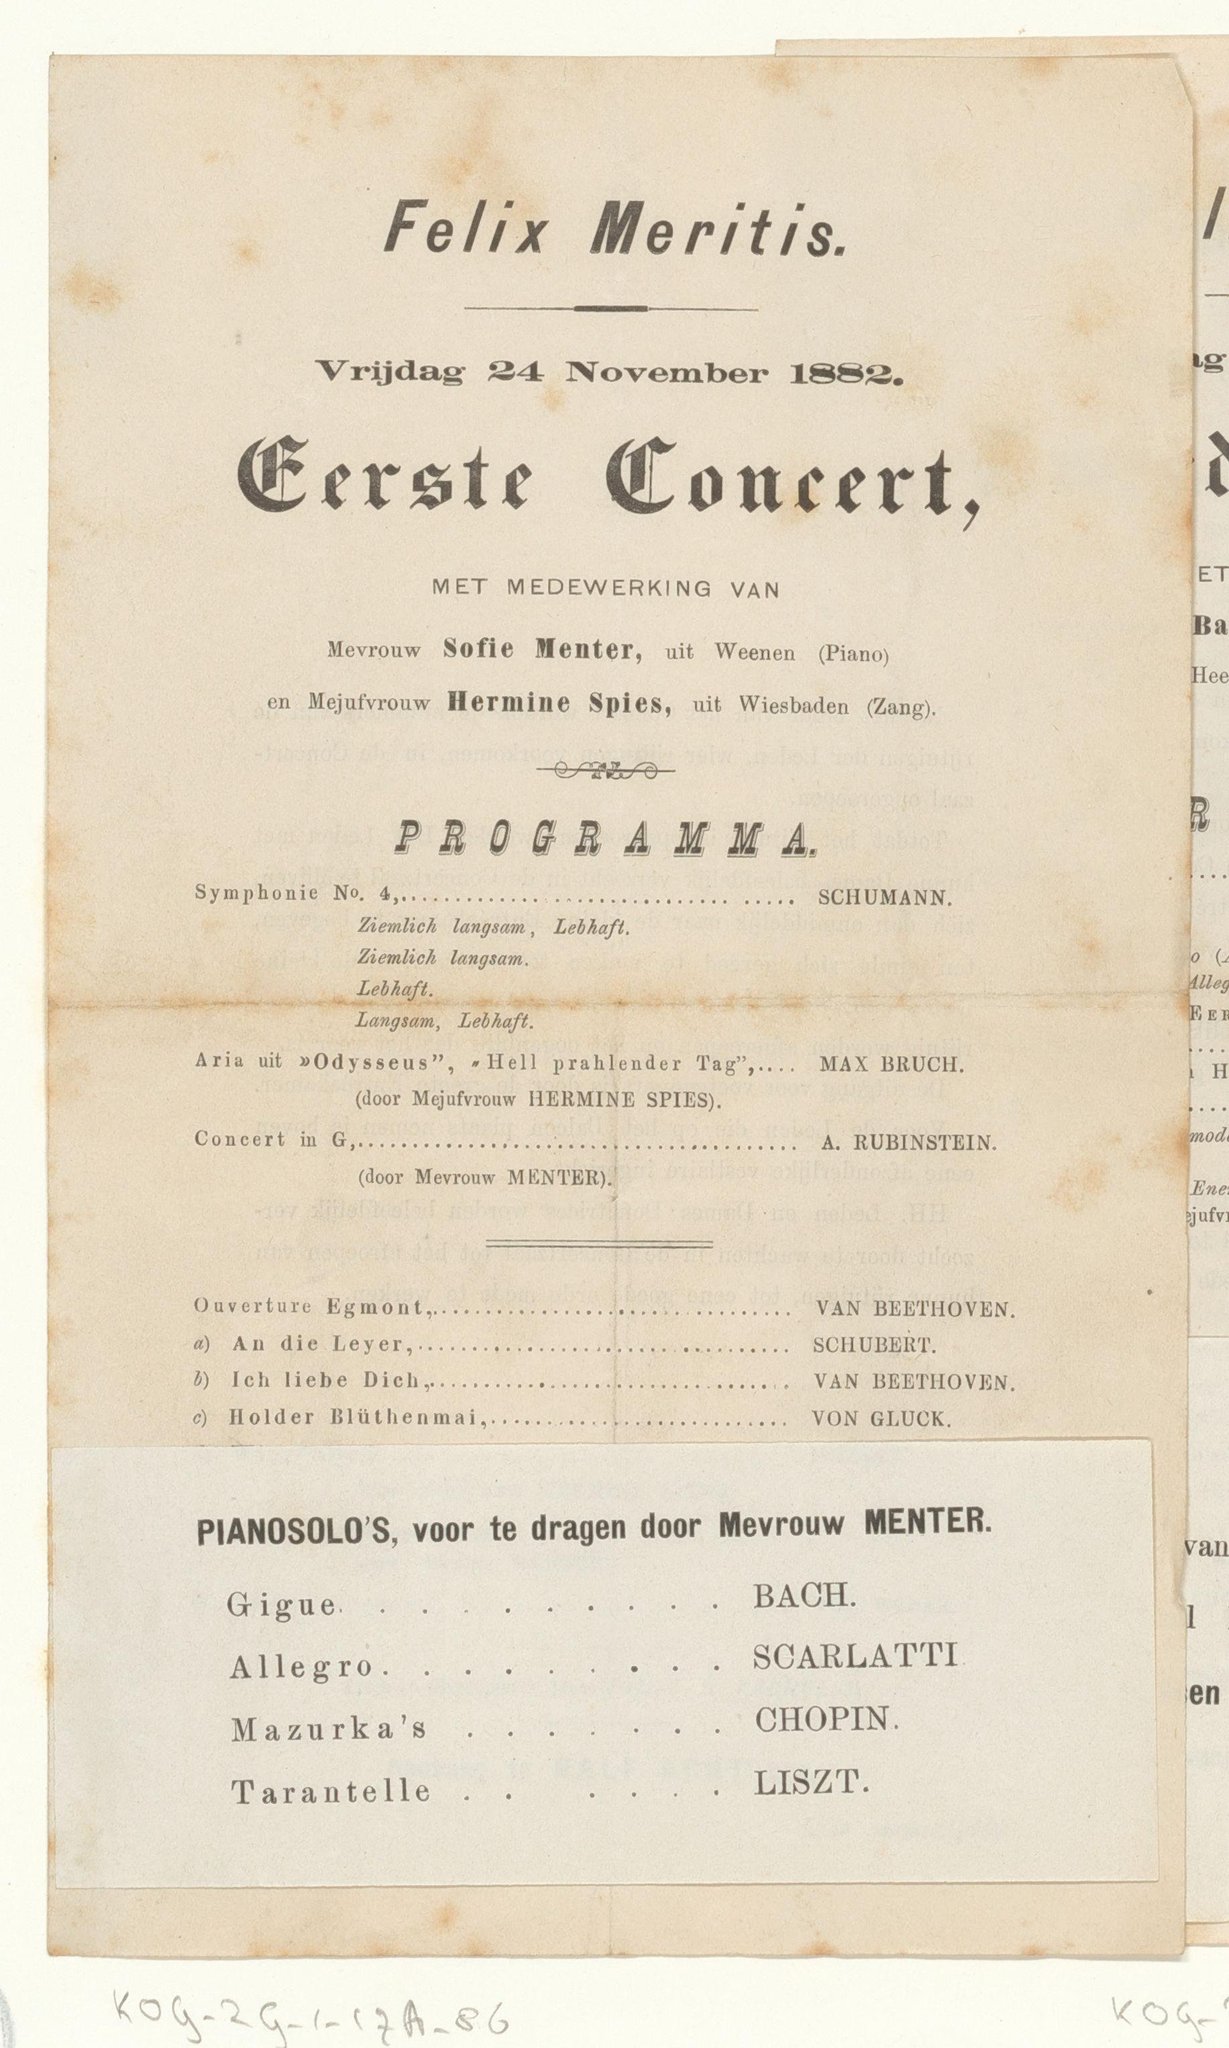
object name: programma, programmaboekje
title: Programma voor een concert in Felix Meritis op 24 november 1882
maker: Anonymous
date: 1882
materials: paper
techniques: letterpress printing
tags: the hague, johannes verhulst, listening to music, large group of musicians, orchestra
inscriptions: collector's mark, collector's mark: Lugt 1641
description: Gedrukt programma voor het Eerste Concert door het orkest onder leiding van Johannes Verhulst, in Felix Meritis te Amsterdam op 24 november 1882. Met vastgeplakt blaadje met de pianosolo's. Onderwerpsrubrieken binnen de Atlas Zeden en Gewoonten: Muziek en muziekinstrumenten: Varia.